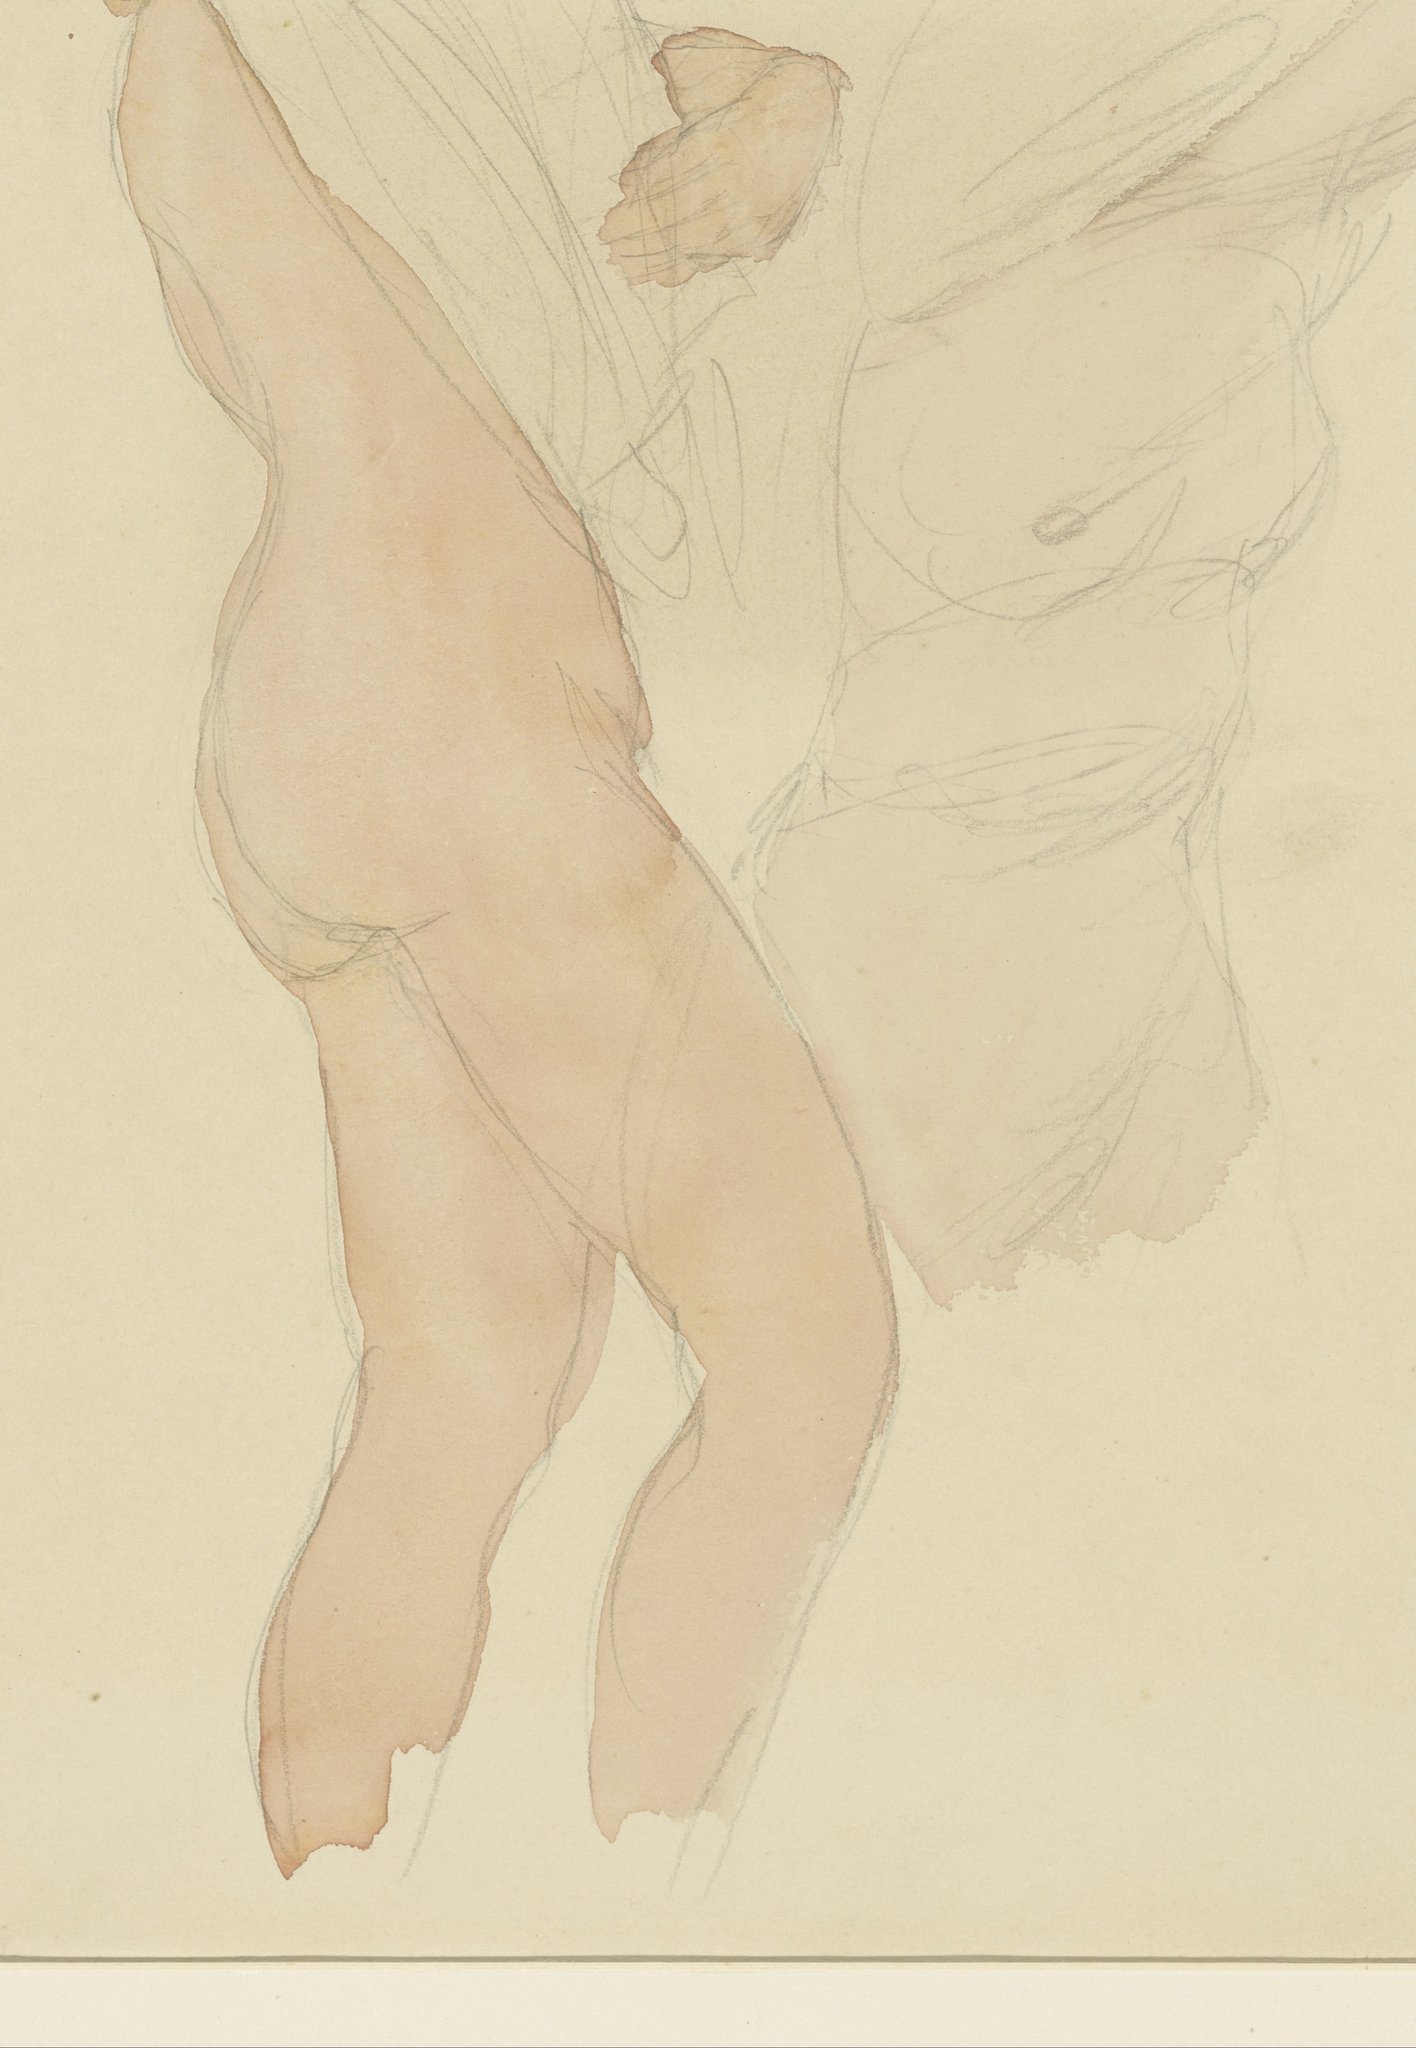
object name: drawing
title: Studieblad met twee vrouwen die hun hemd uittrekken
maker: auguste rodin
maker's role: draughtsman, print maker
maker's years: 1840-1917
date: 1850-1917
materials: paper, pencil, watercolor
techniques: brush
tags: undressing oneself, getting undressed - aa - female human figure